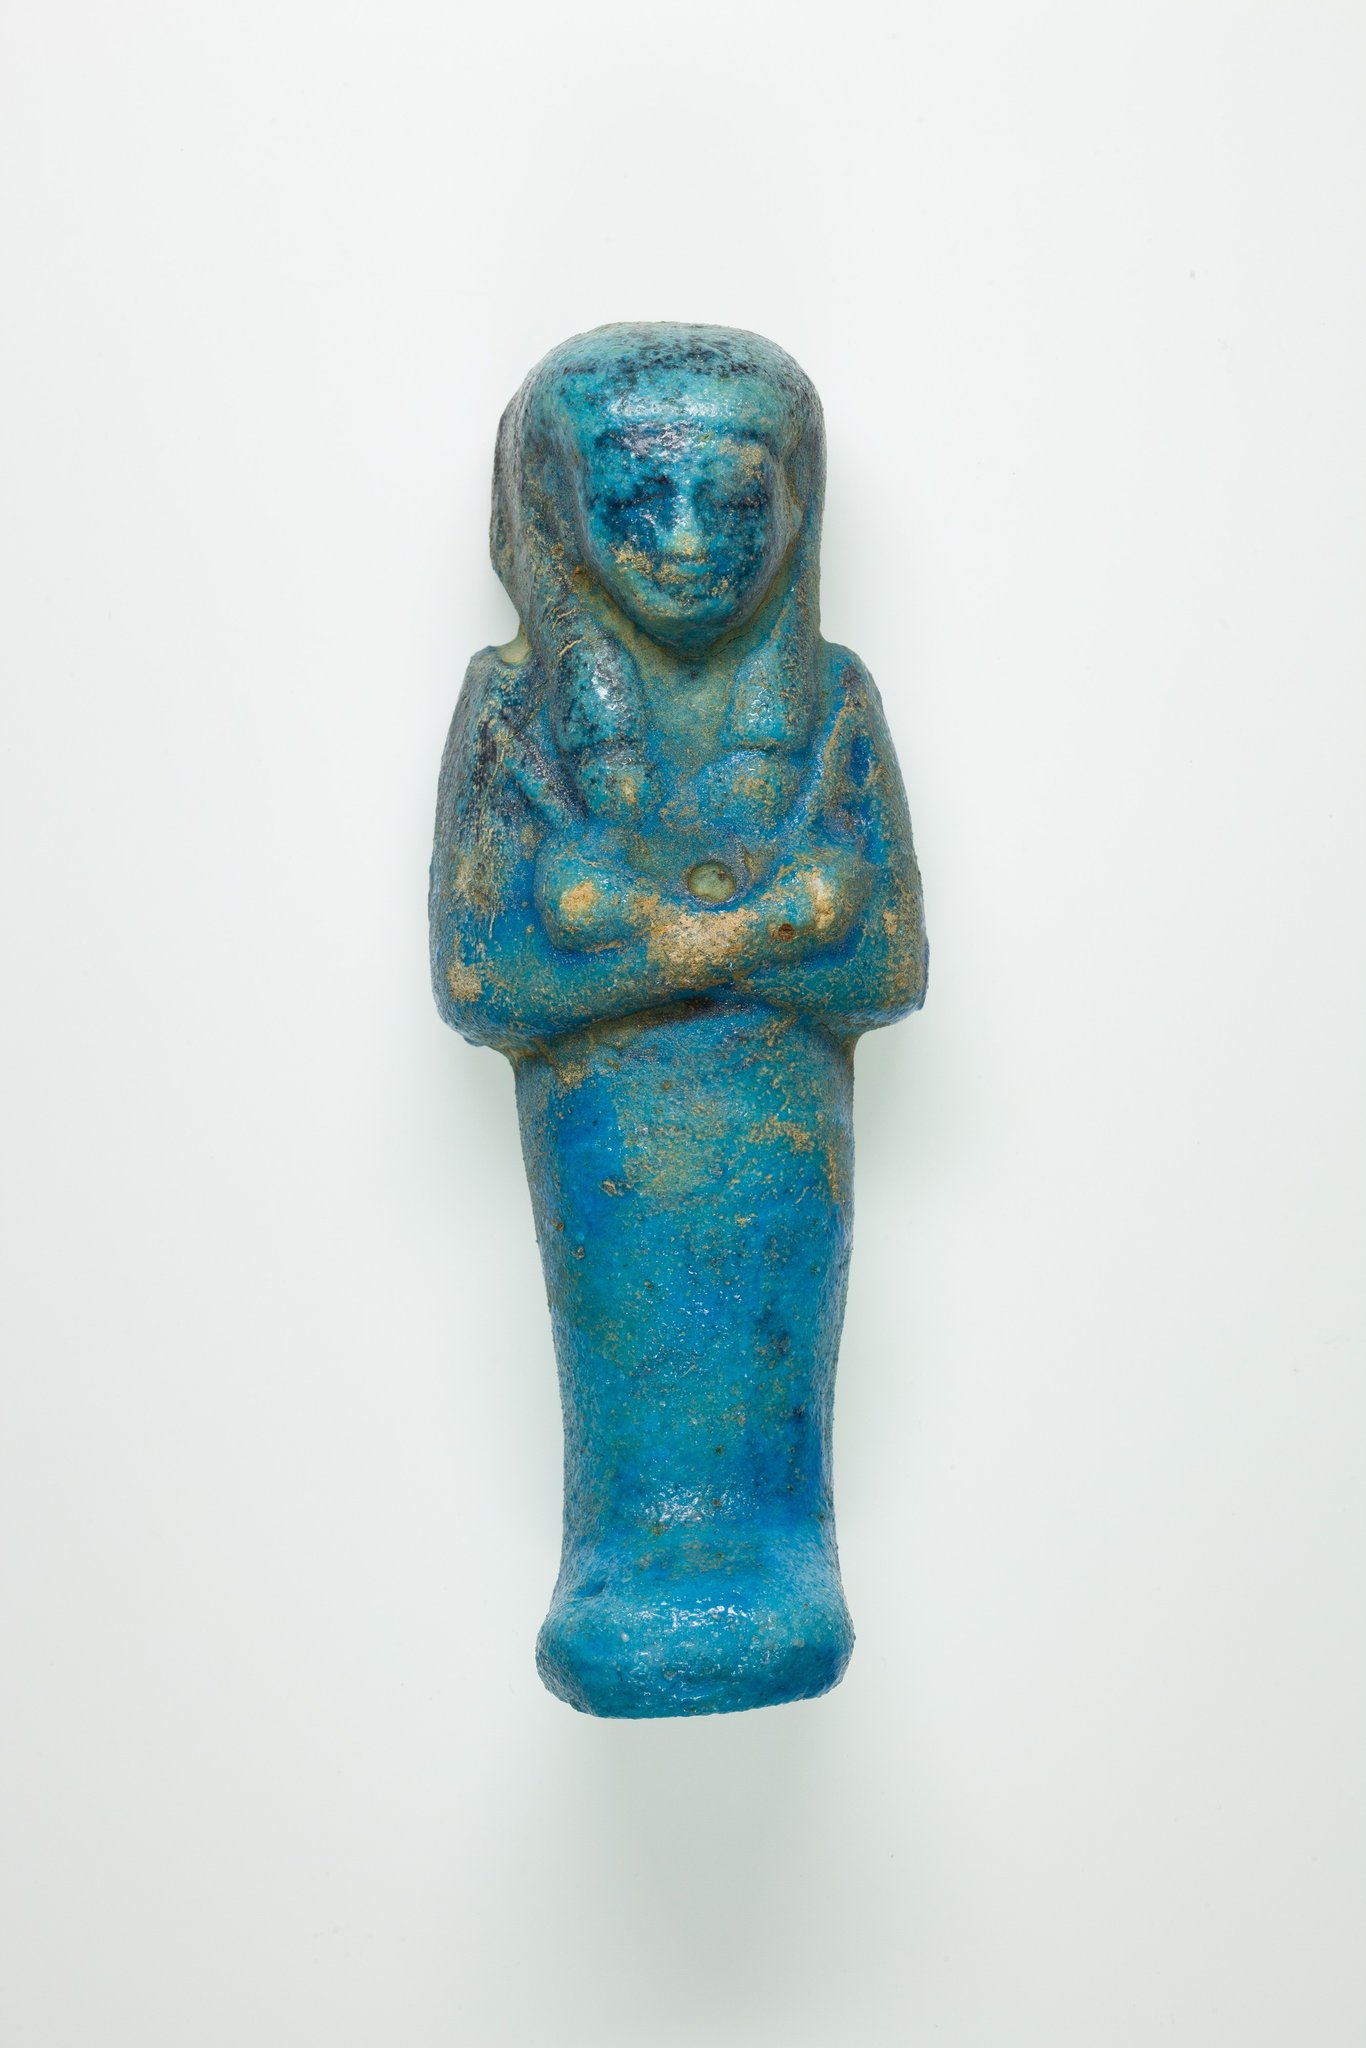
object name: worker shabti, henettawy c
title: Worker Shabti of Henettawy (C), Daughter of Isetemkheb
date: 990-970 BCE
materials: faience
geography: egypt